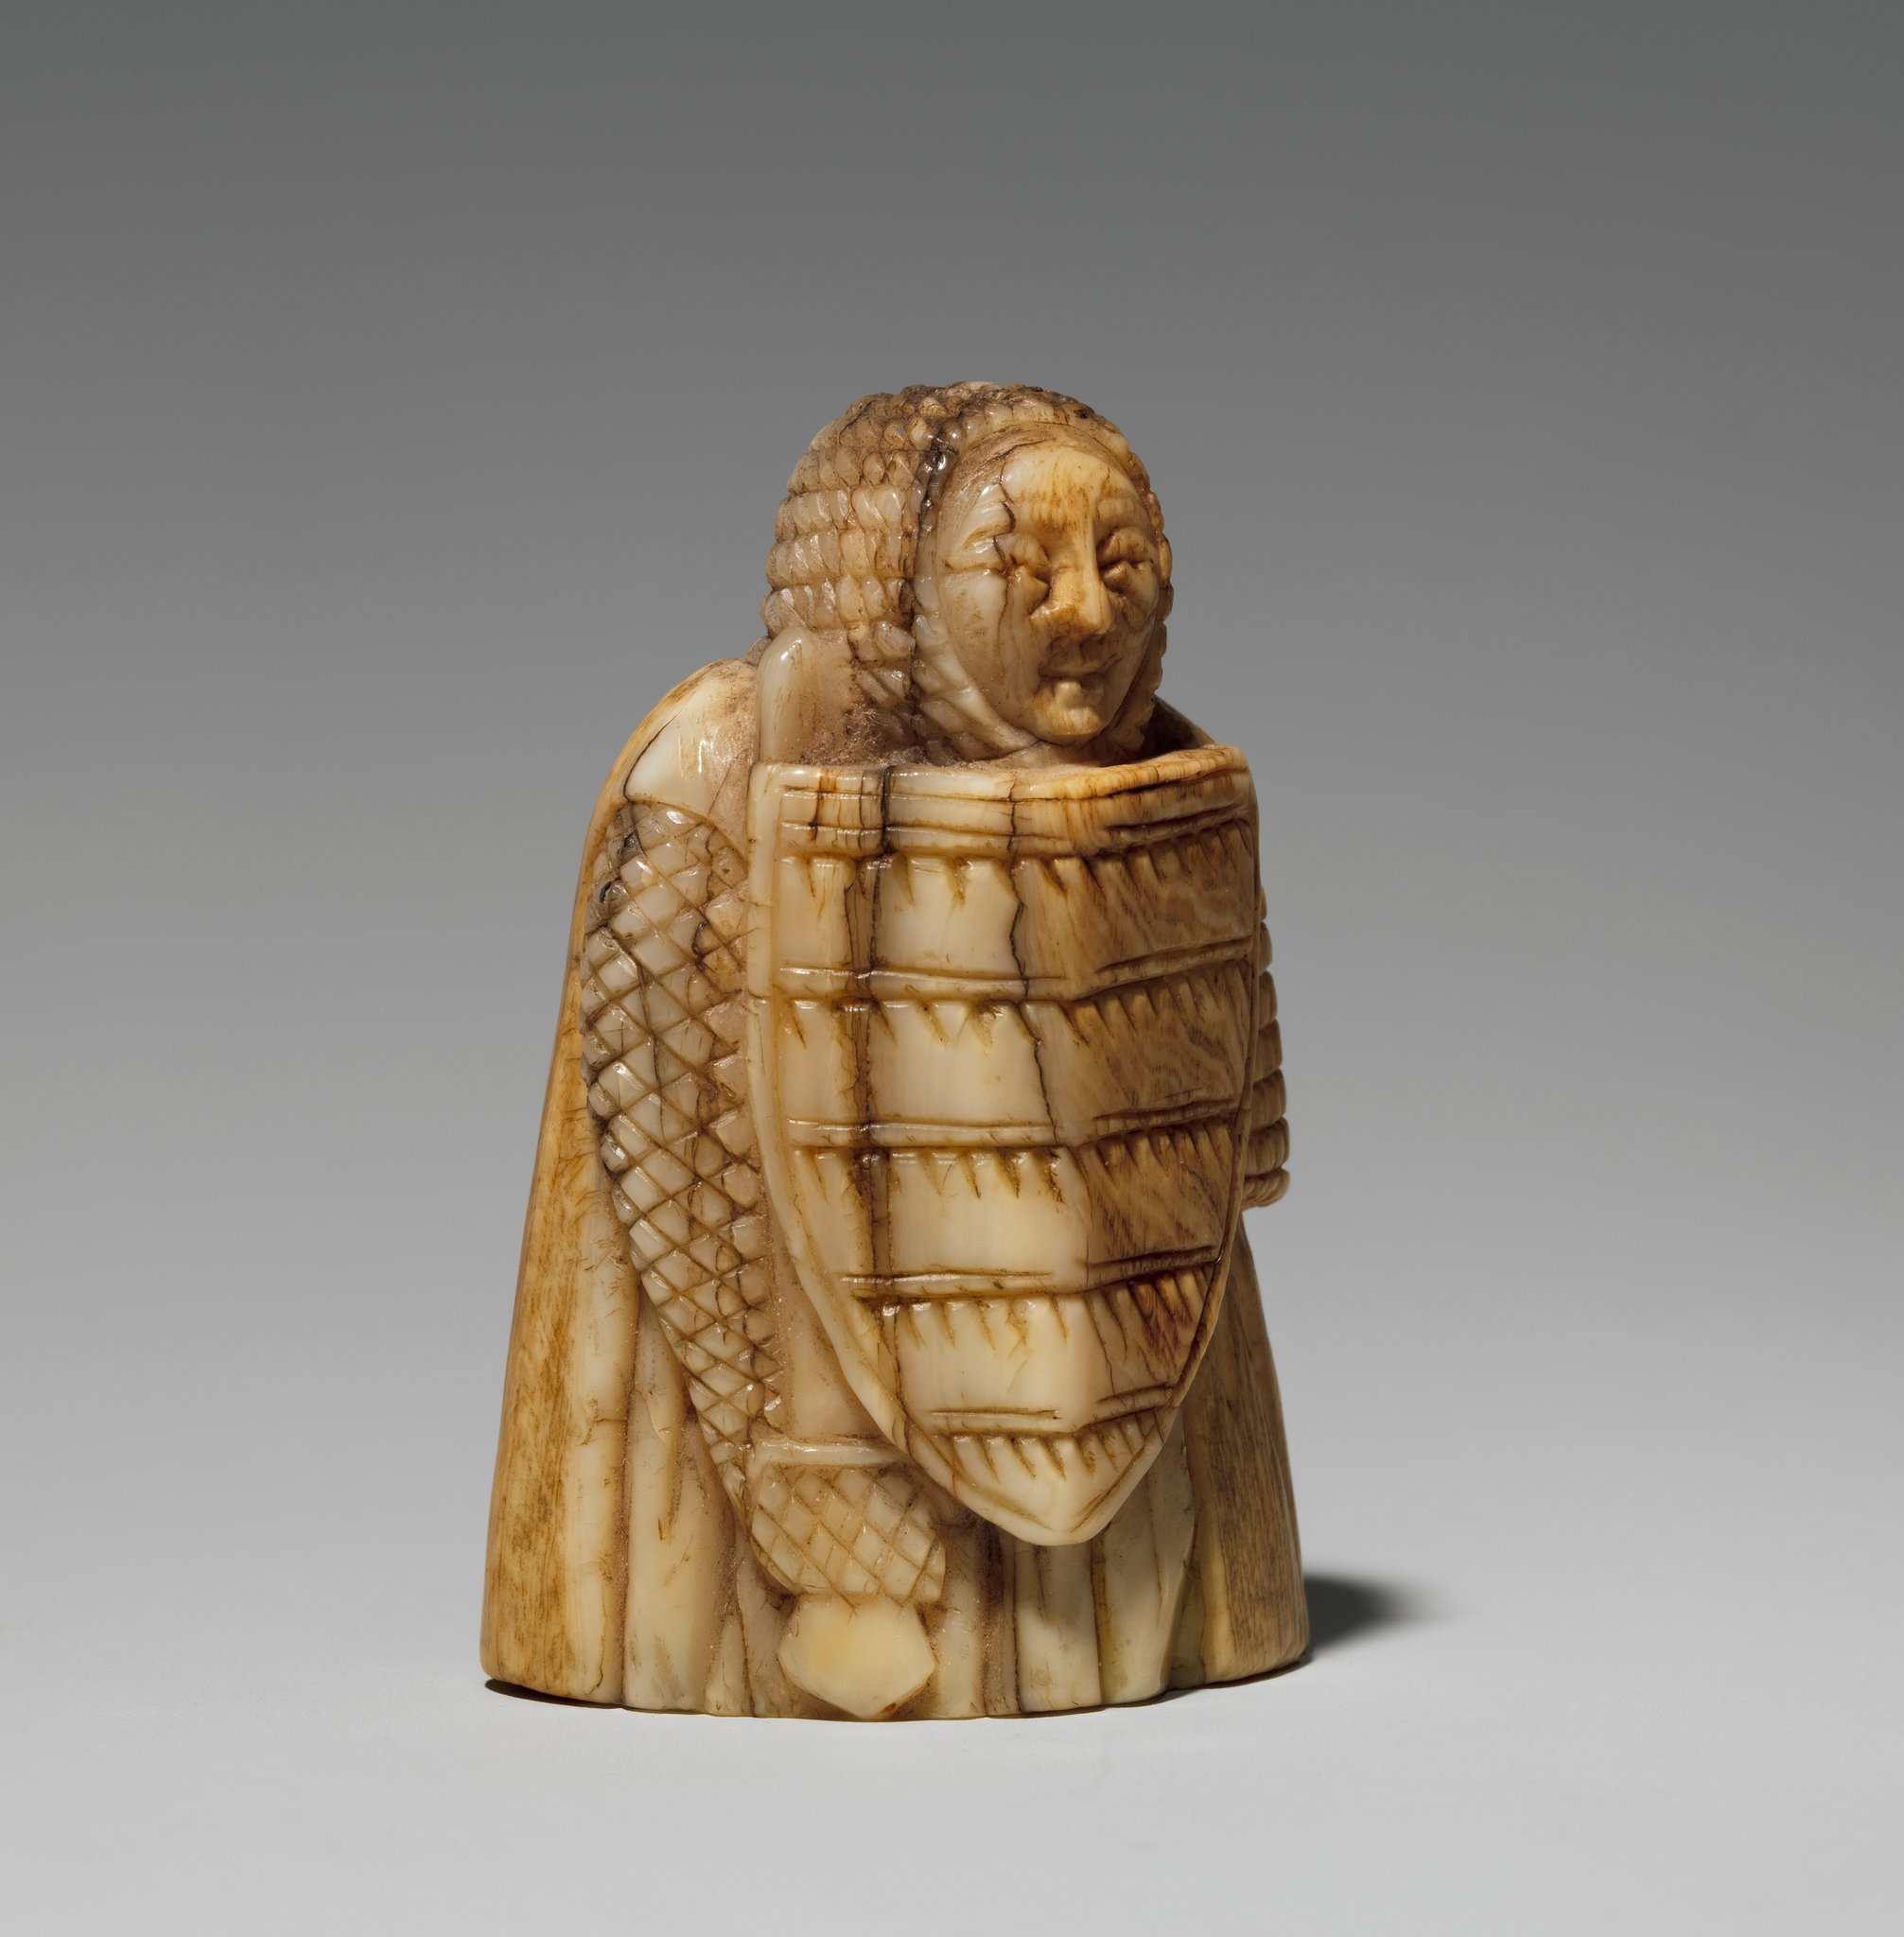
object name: chess piece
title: Rook or Pawn Chess Piece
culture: scandinavian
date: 1101-1200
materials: ivory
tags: chess